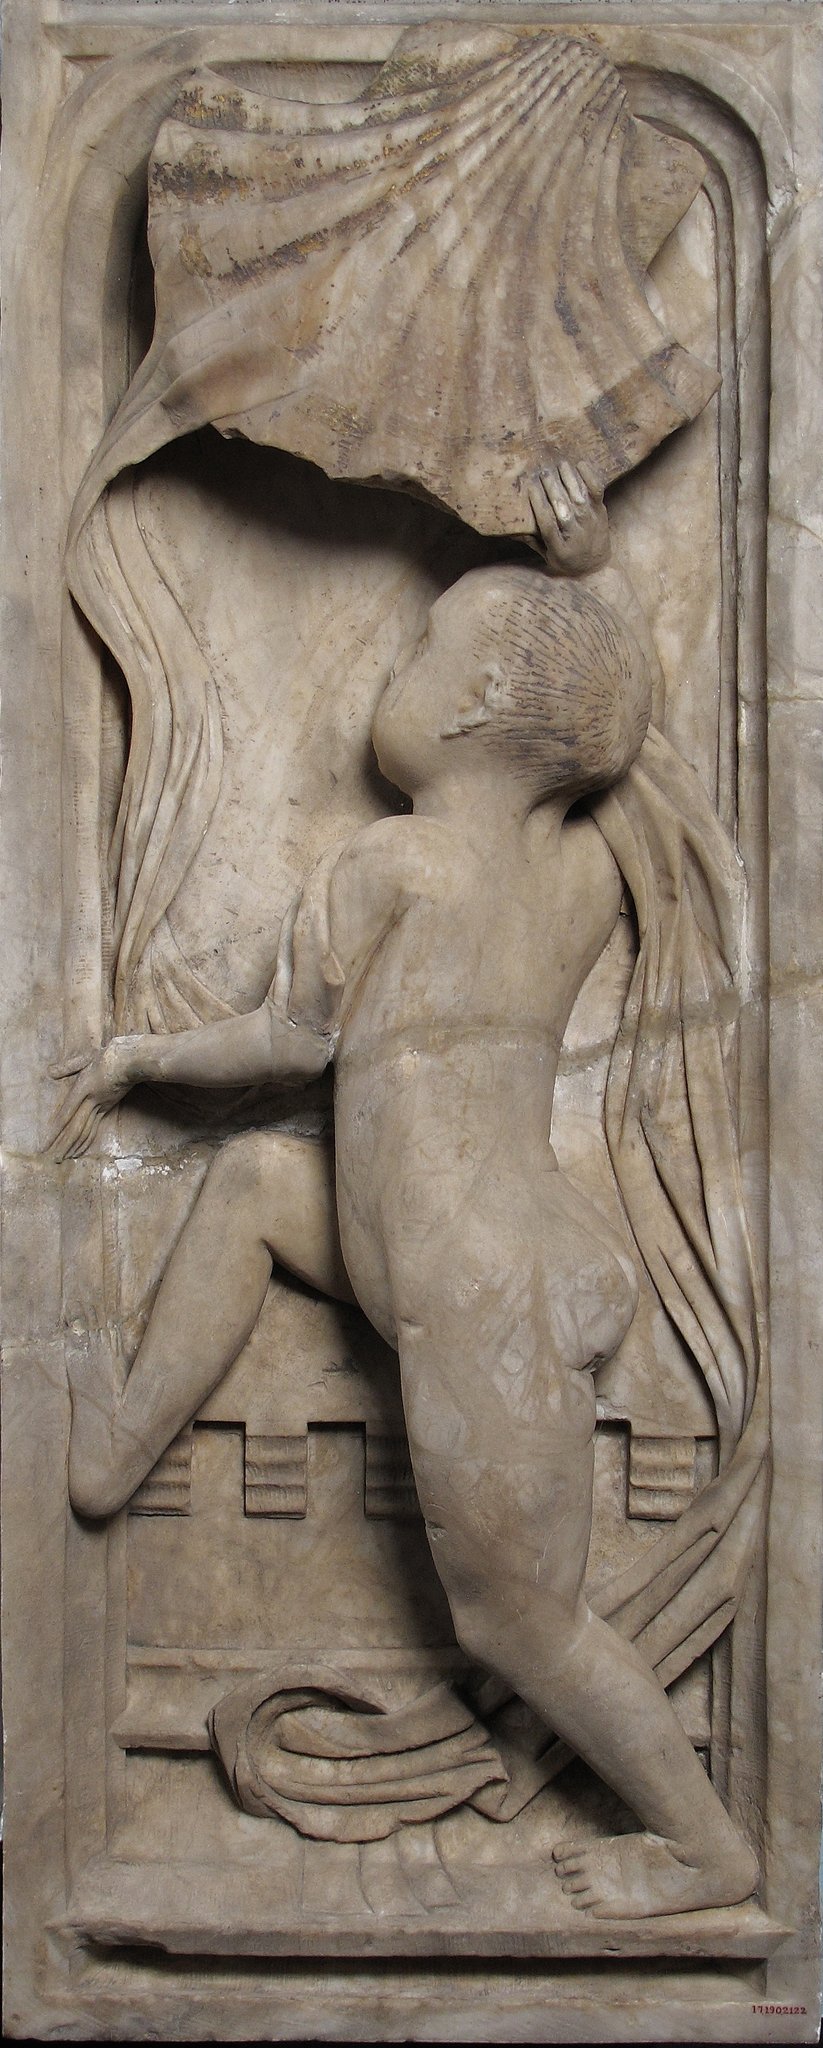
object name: panel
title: Panel from the Tomb of Don Garcia Osorio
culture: spanish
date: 1501-1600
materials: alabaster